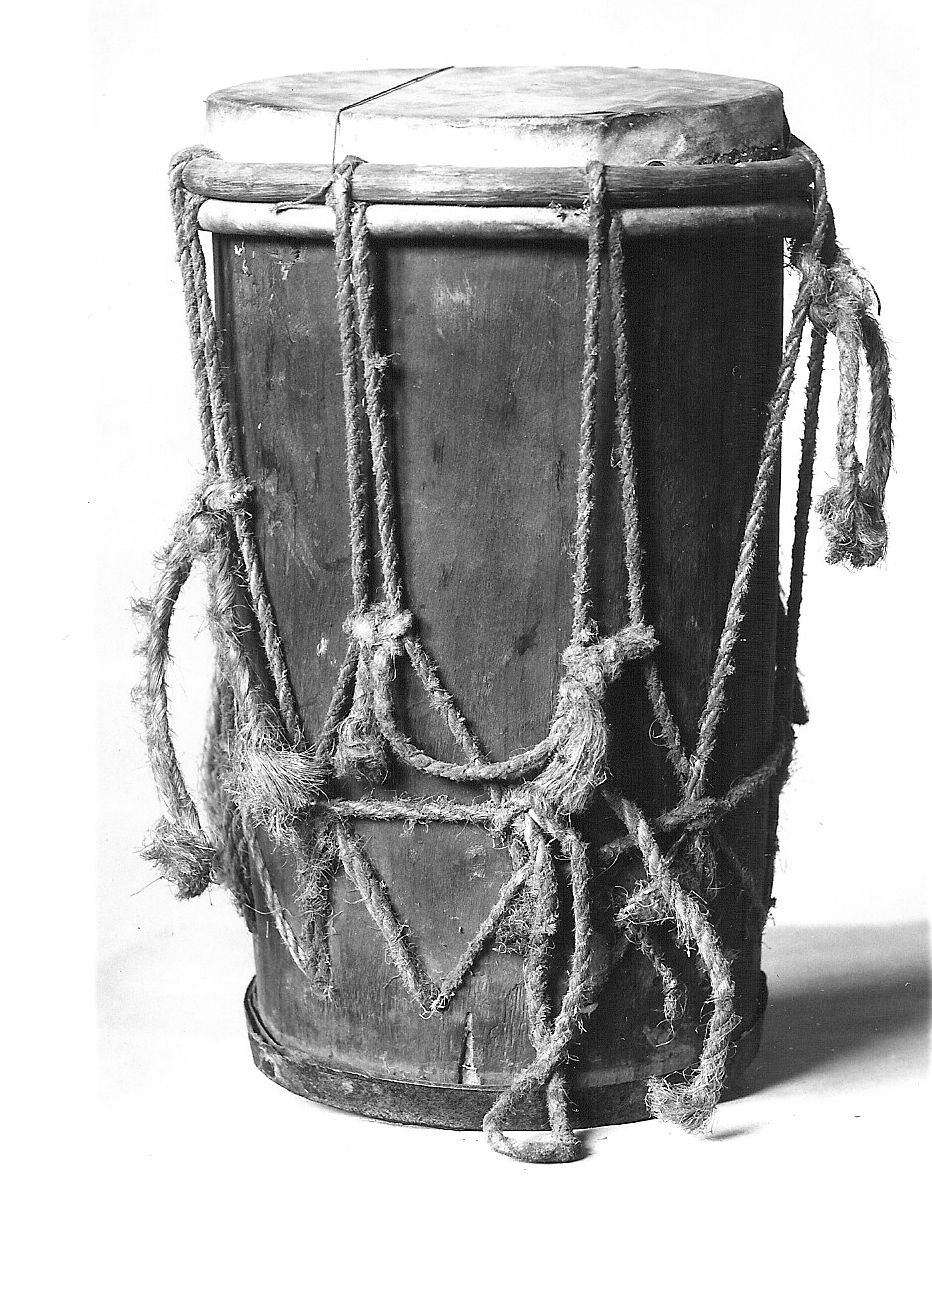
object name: drum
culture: african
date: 1801-1900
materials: fiber, wood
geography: sub-sahara